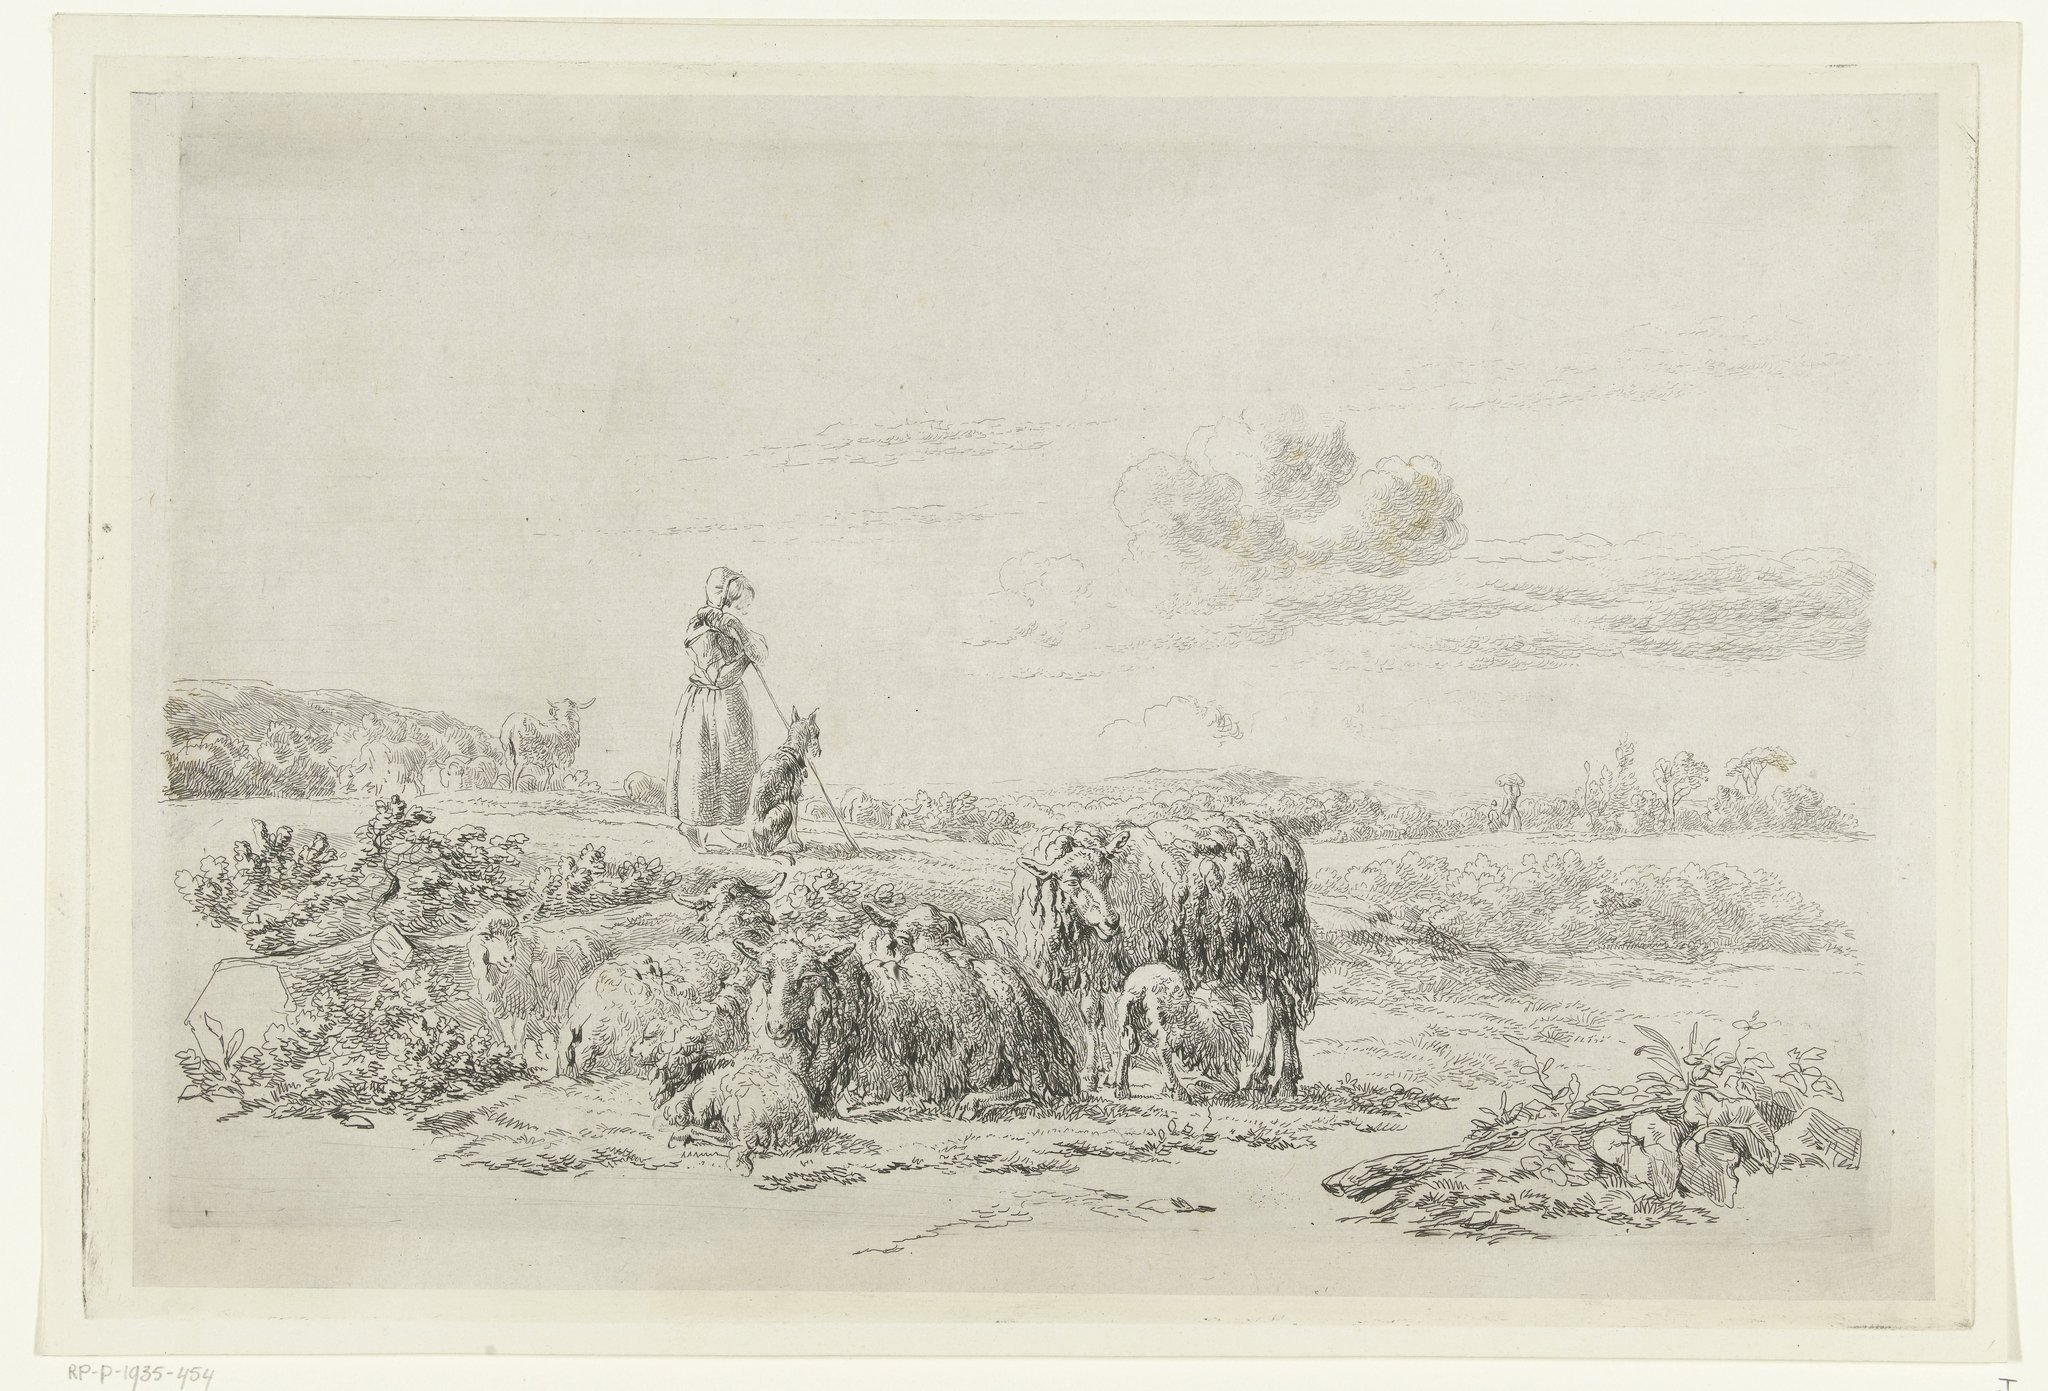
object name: print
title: Landschap met herderin en hond bij kudde schapen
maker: simon van den berg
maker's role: draughtsman, print maker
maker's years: 1812-1891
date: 1822-1899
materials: paper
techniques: drypoint, etching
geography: netherlands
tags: herding, herdsman, herdswoman, shepherd, shepherdess, cowherd, etc., sheep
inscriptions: collector's mark: Lugt 2760, collector's mark: Lugt 2228